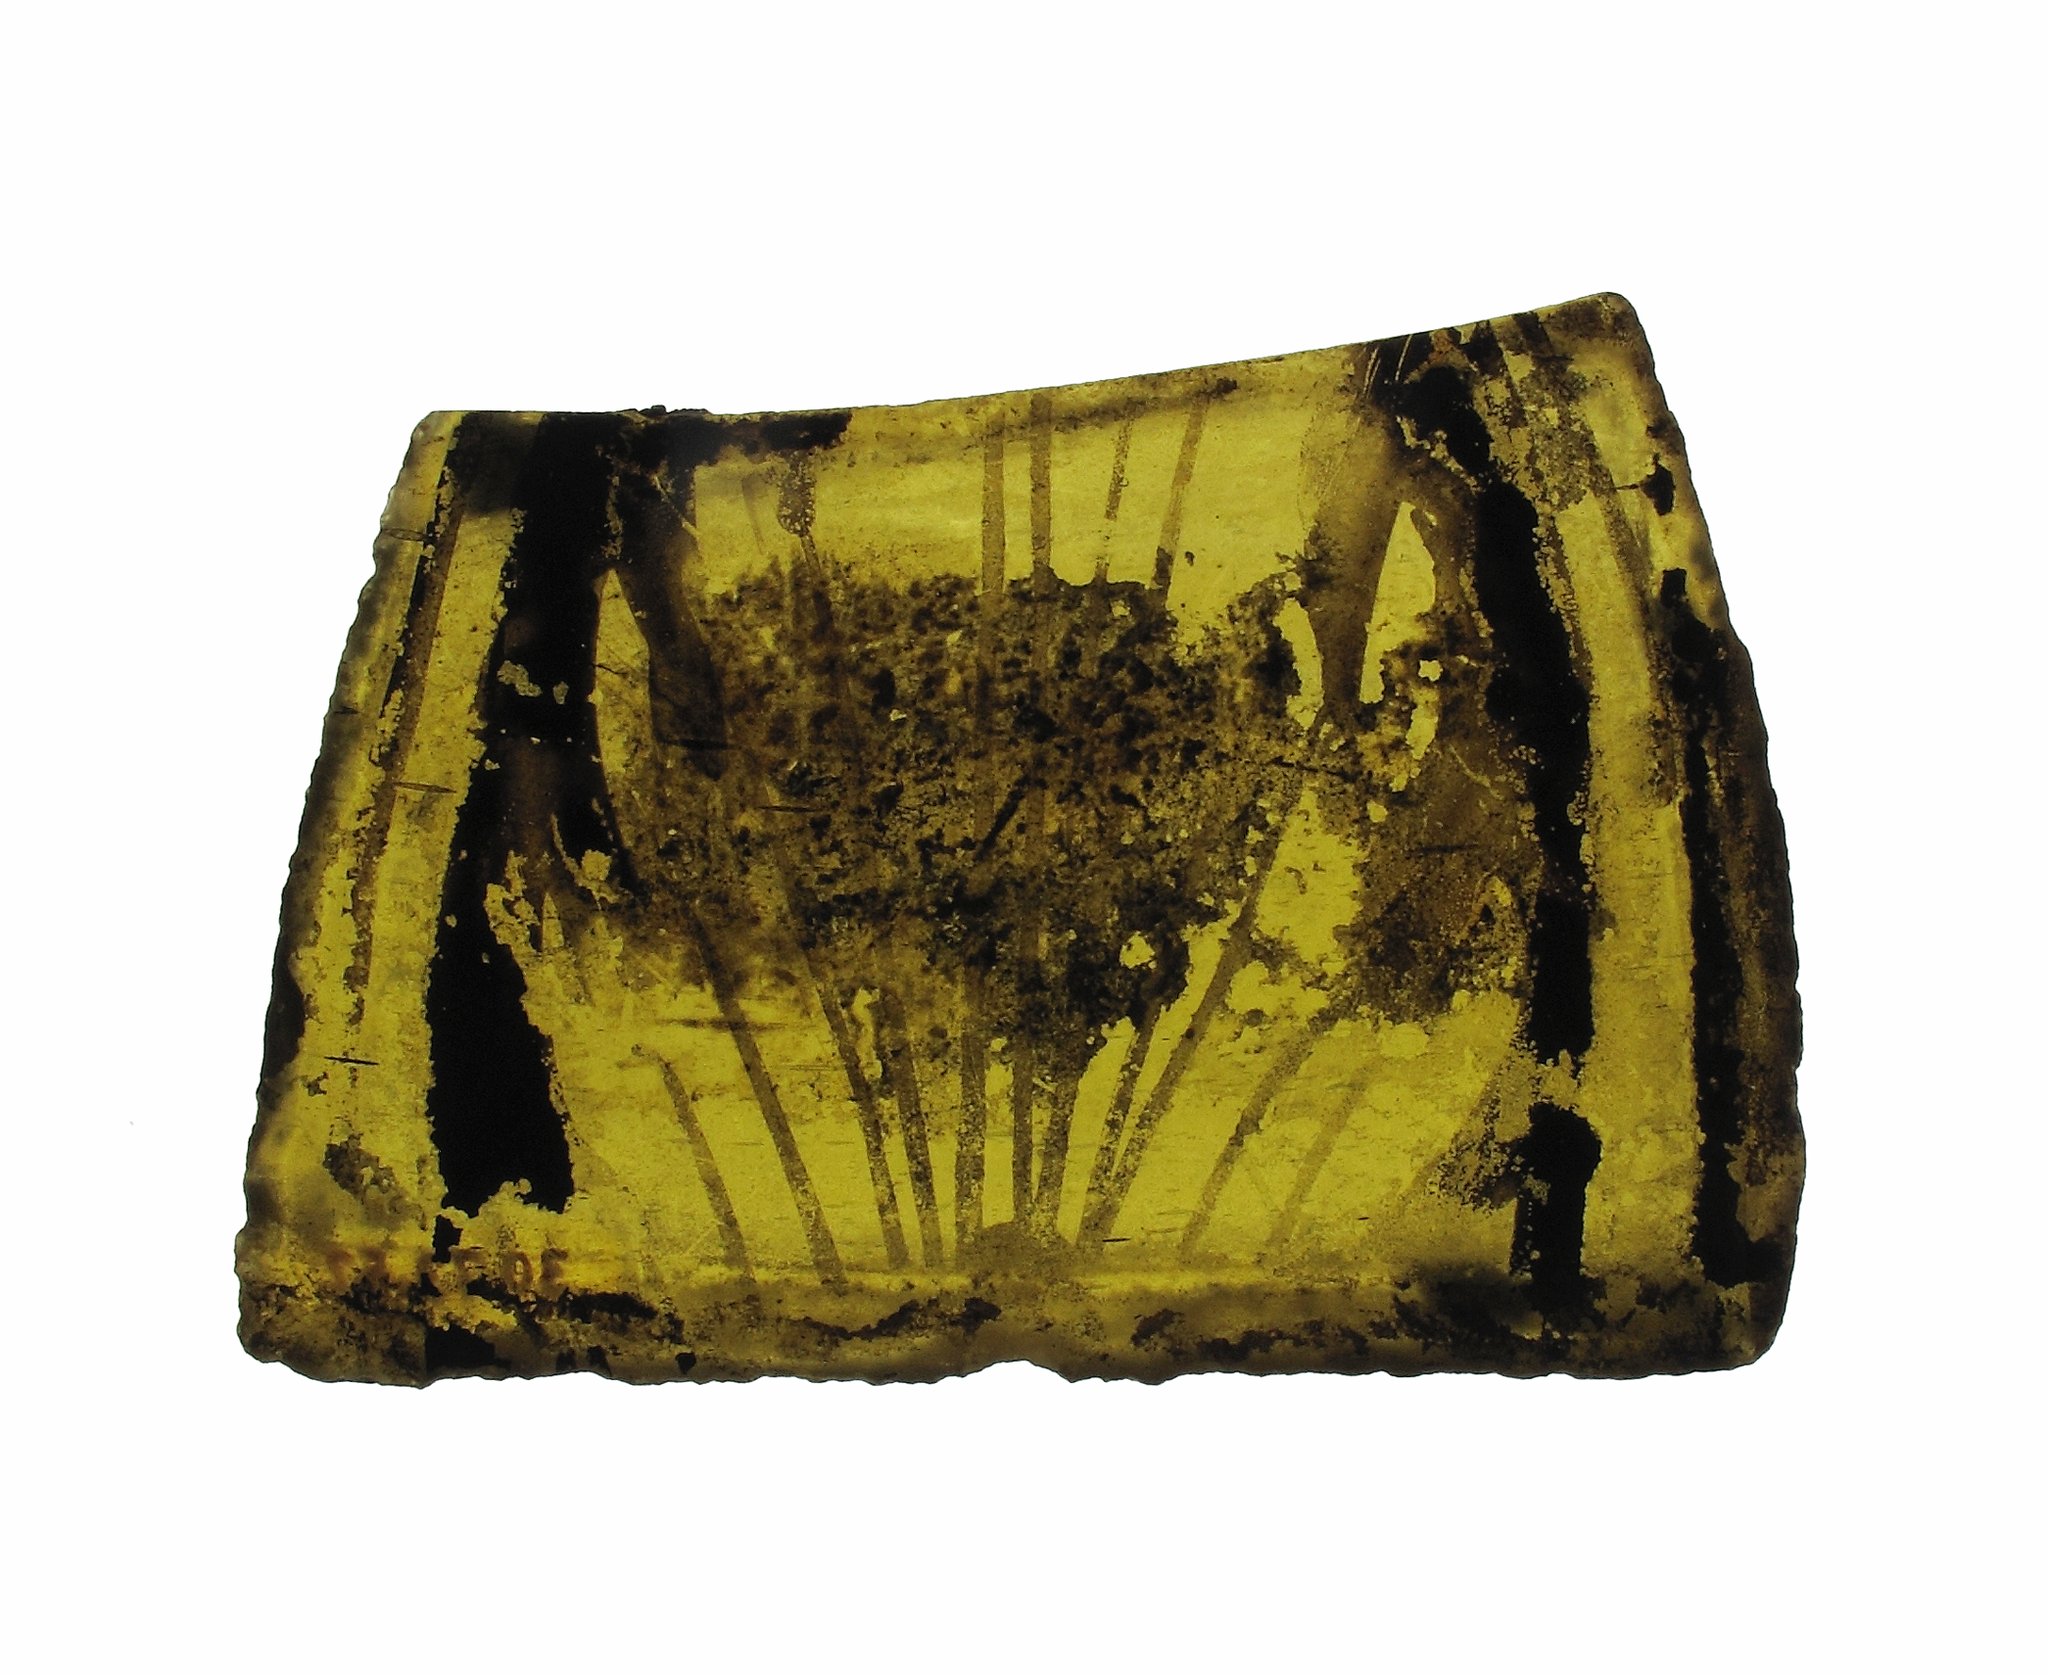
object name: fragment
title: Glass Fragment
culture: european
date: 1401-1500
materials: glass, metal